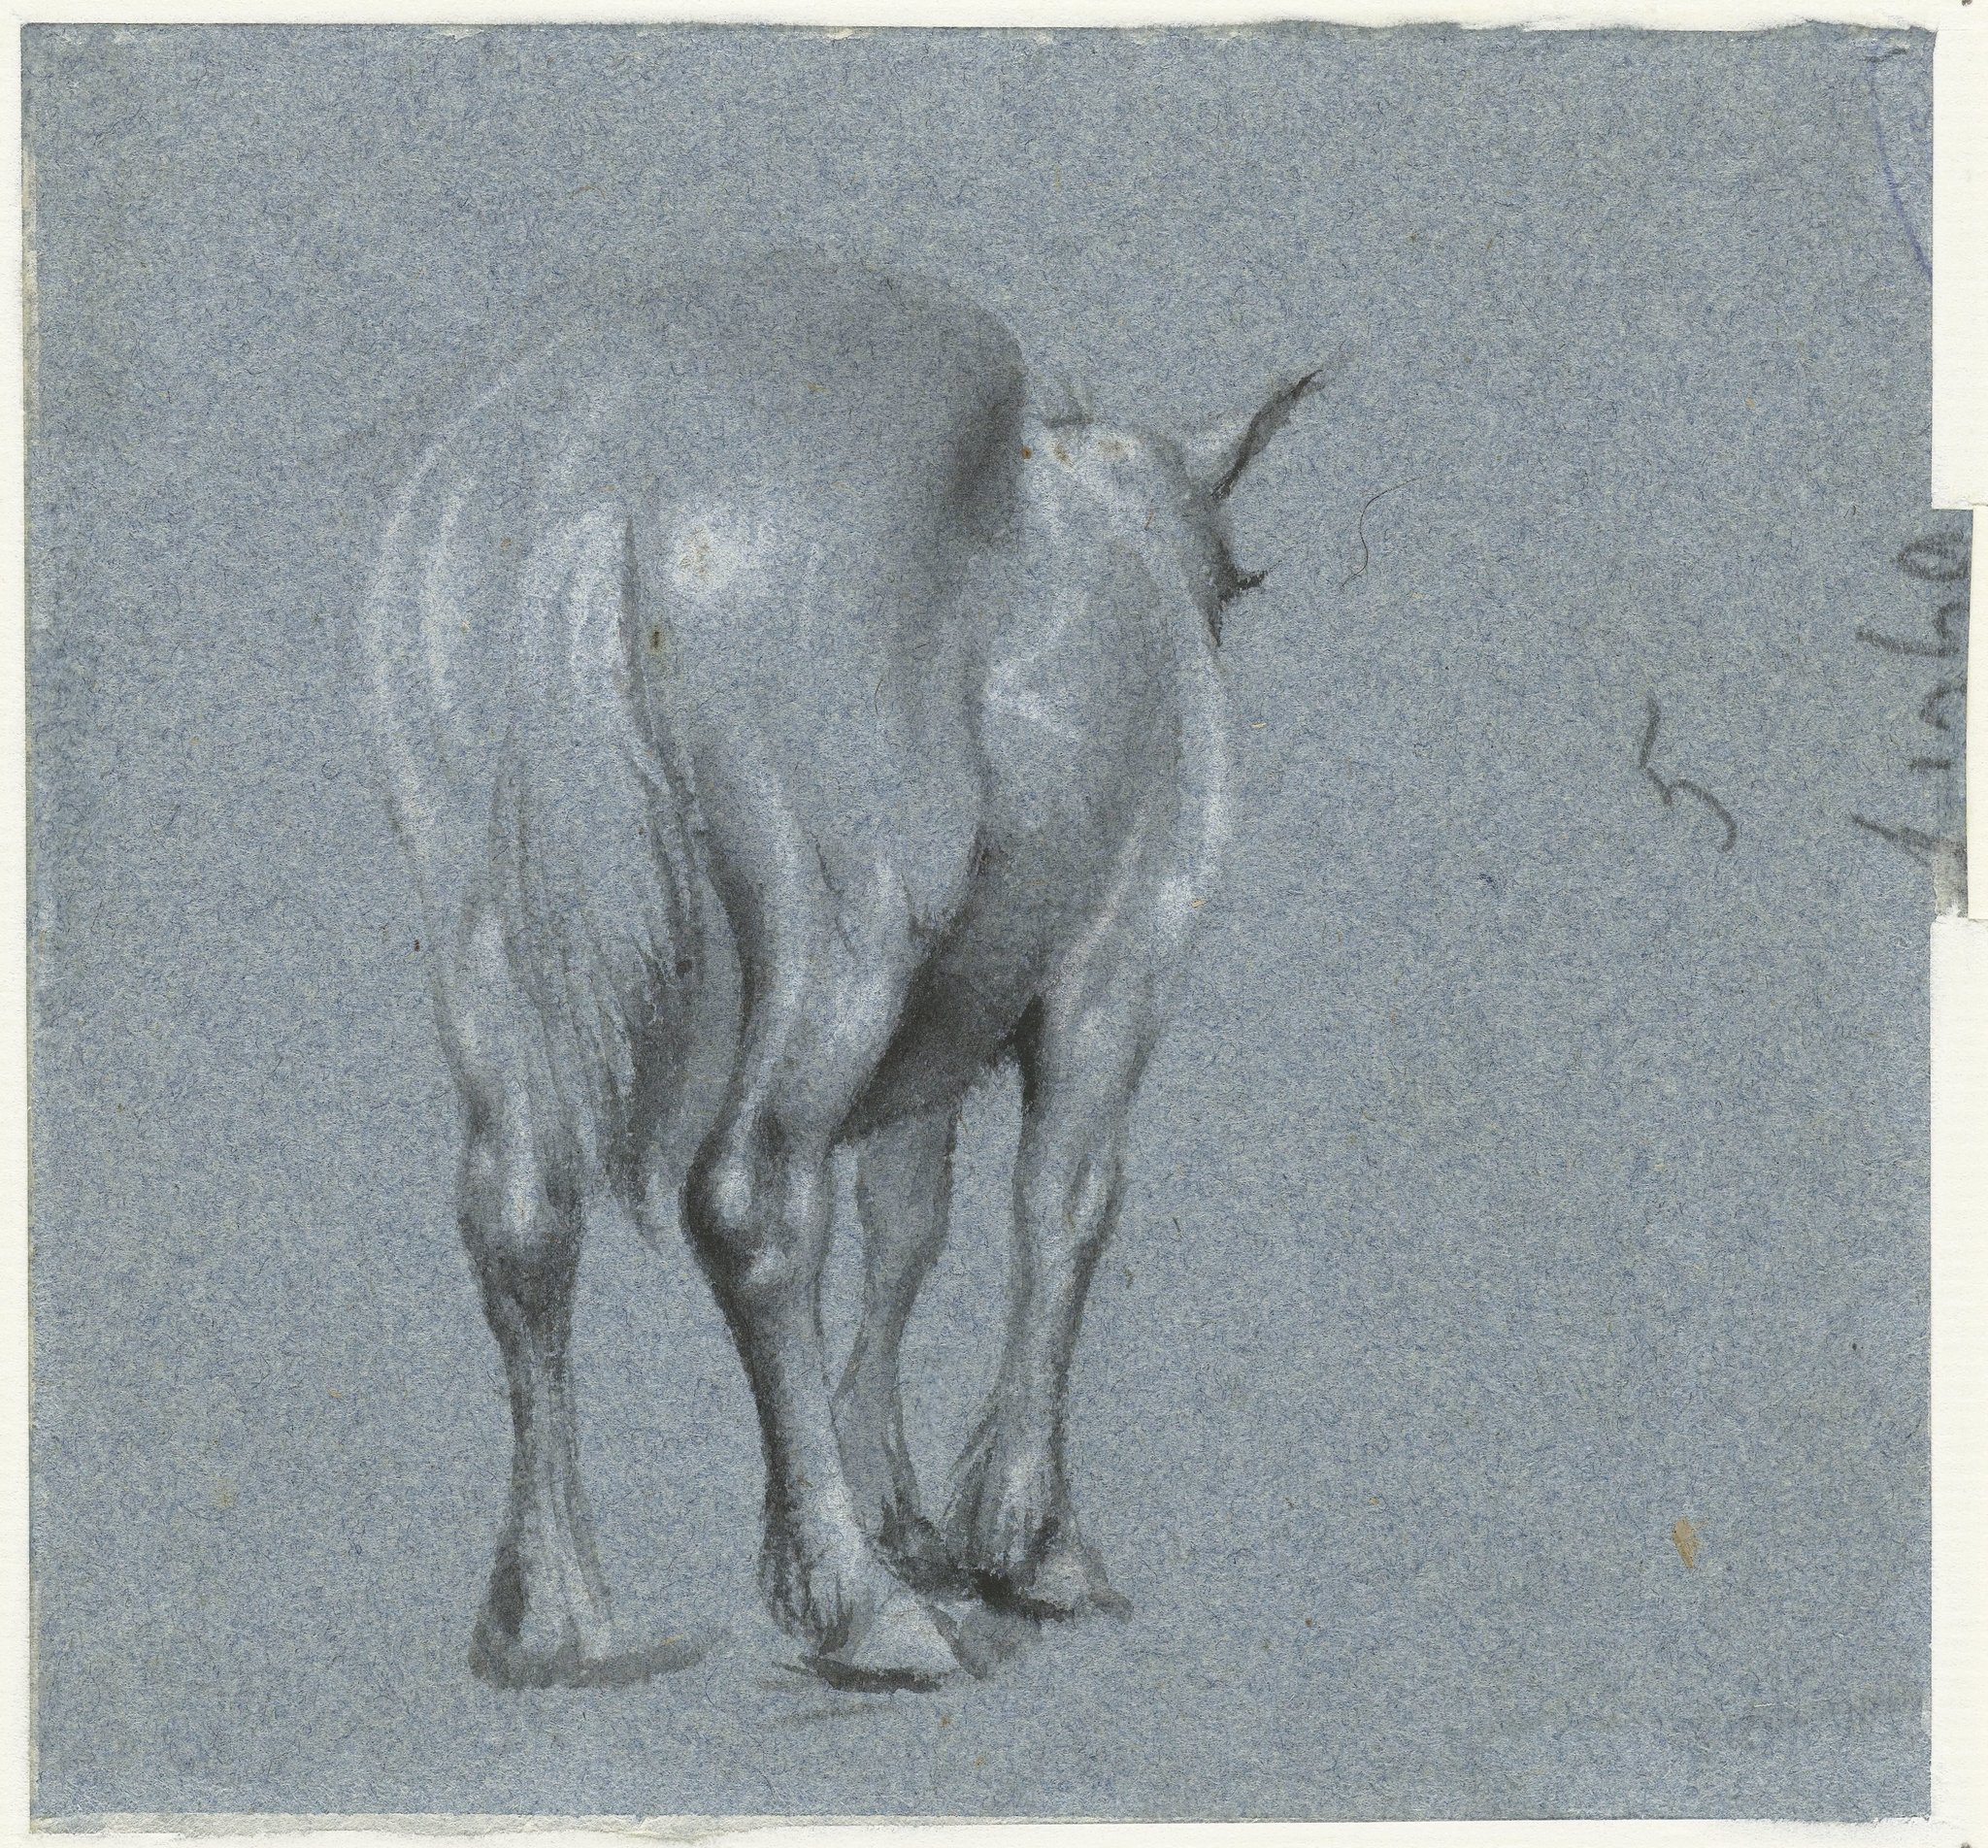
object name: drawing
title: Staande werkpaarden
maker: moses ter borch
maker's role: draughtsman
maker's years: 1645-1667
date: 1660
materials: chalk, ink, paper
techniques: brush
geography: zwolle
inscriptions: annotation: ‘5’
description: Blad uit serie van 8 tekeningen van werkpaarden, waarschijnlijk naar het leven getekend.